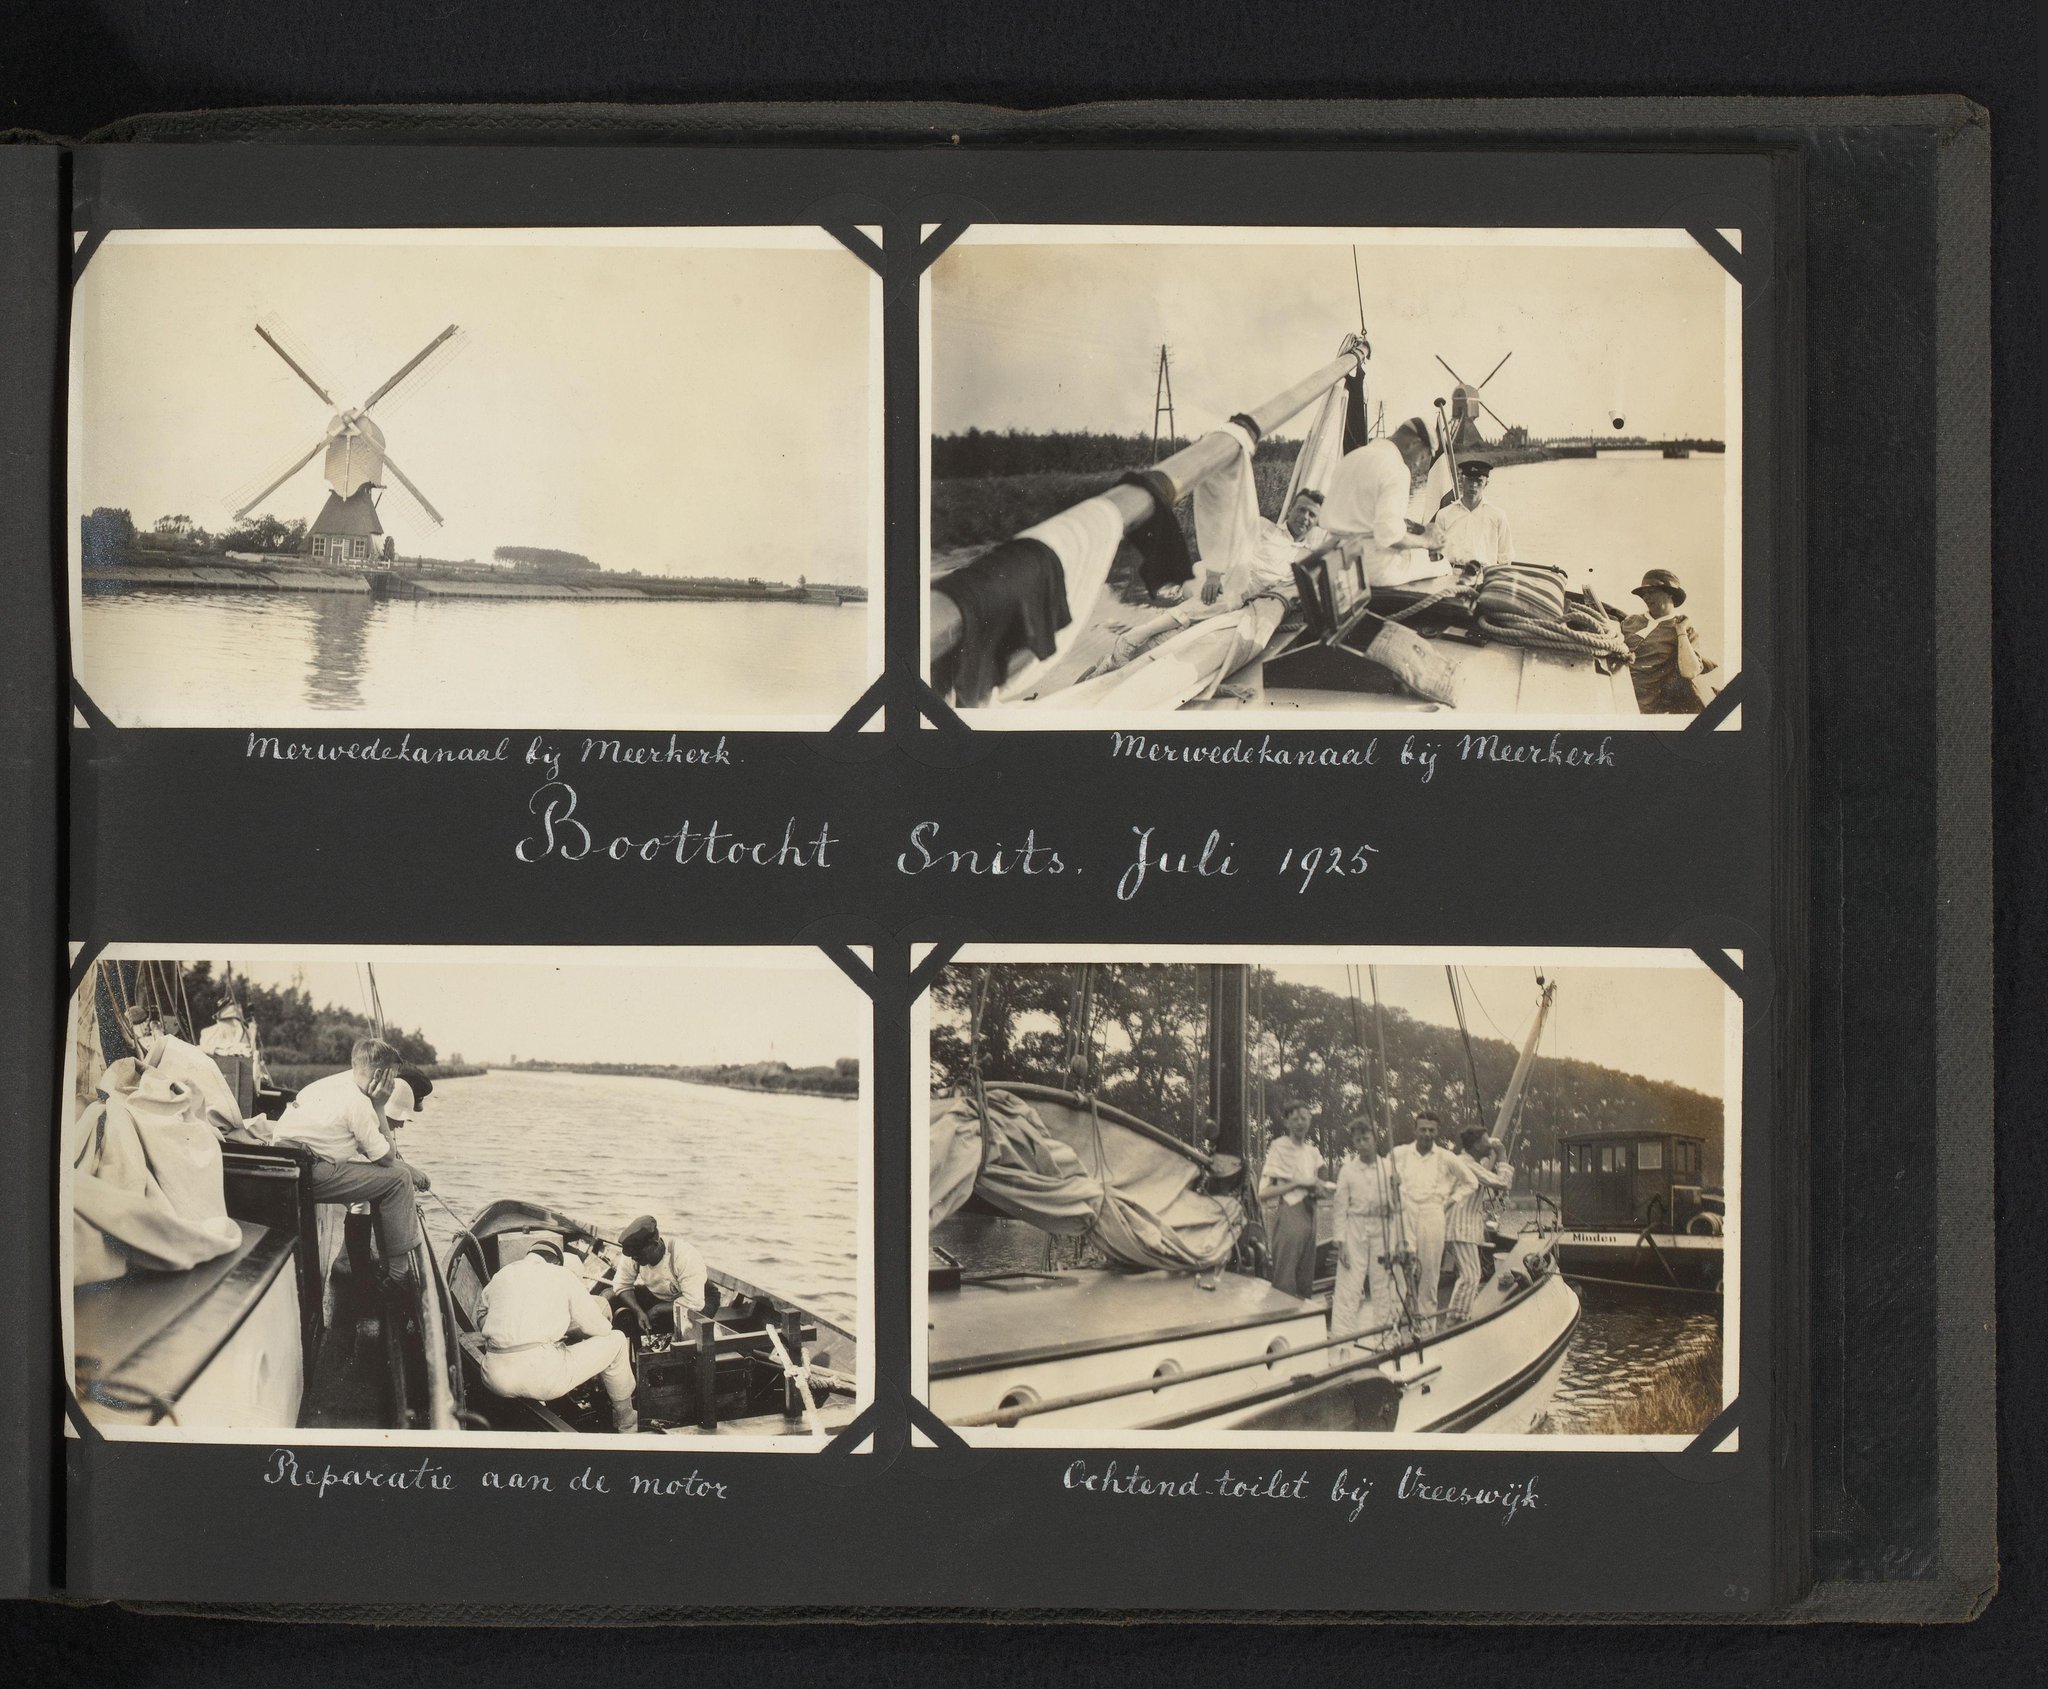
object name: photograph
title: Vier foto's van een boottocht met zeilboot de Snits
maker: hendrik herman van den berg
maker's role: amateurfotograaf, jurist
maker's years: 1875-1944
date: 1907-1925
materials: paper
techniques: gelatin silver print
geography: utrecht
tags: sailing-ship, sailing-boat, windmill in landscape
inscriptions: inscription: ‘Merwedekanaal bij Meerkerk’, inscription: ‘Merwedekanaal bij Meerkerk’, inscription: ‘Ochtend-toilet bij Vreeswijk’, inscription: ‘Reparatie aan de motor’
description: Deze foto's maken deel uit van een album.